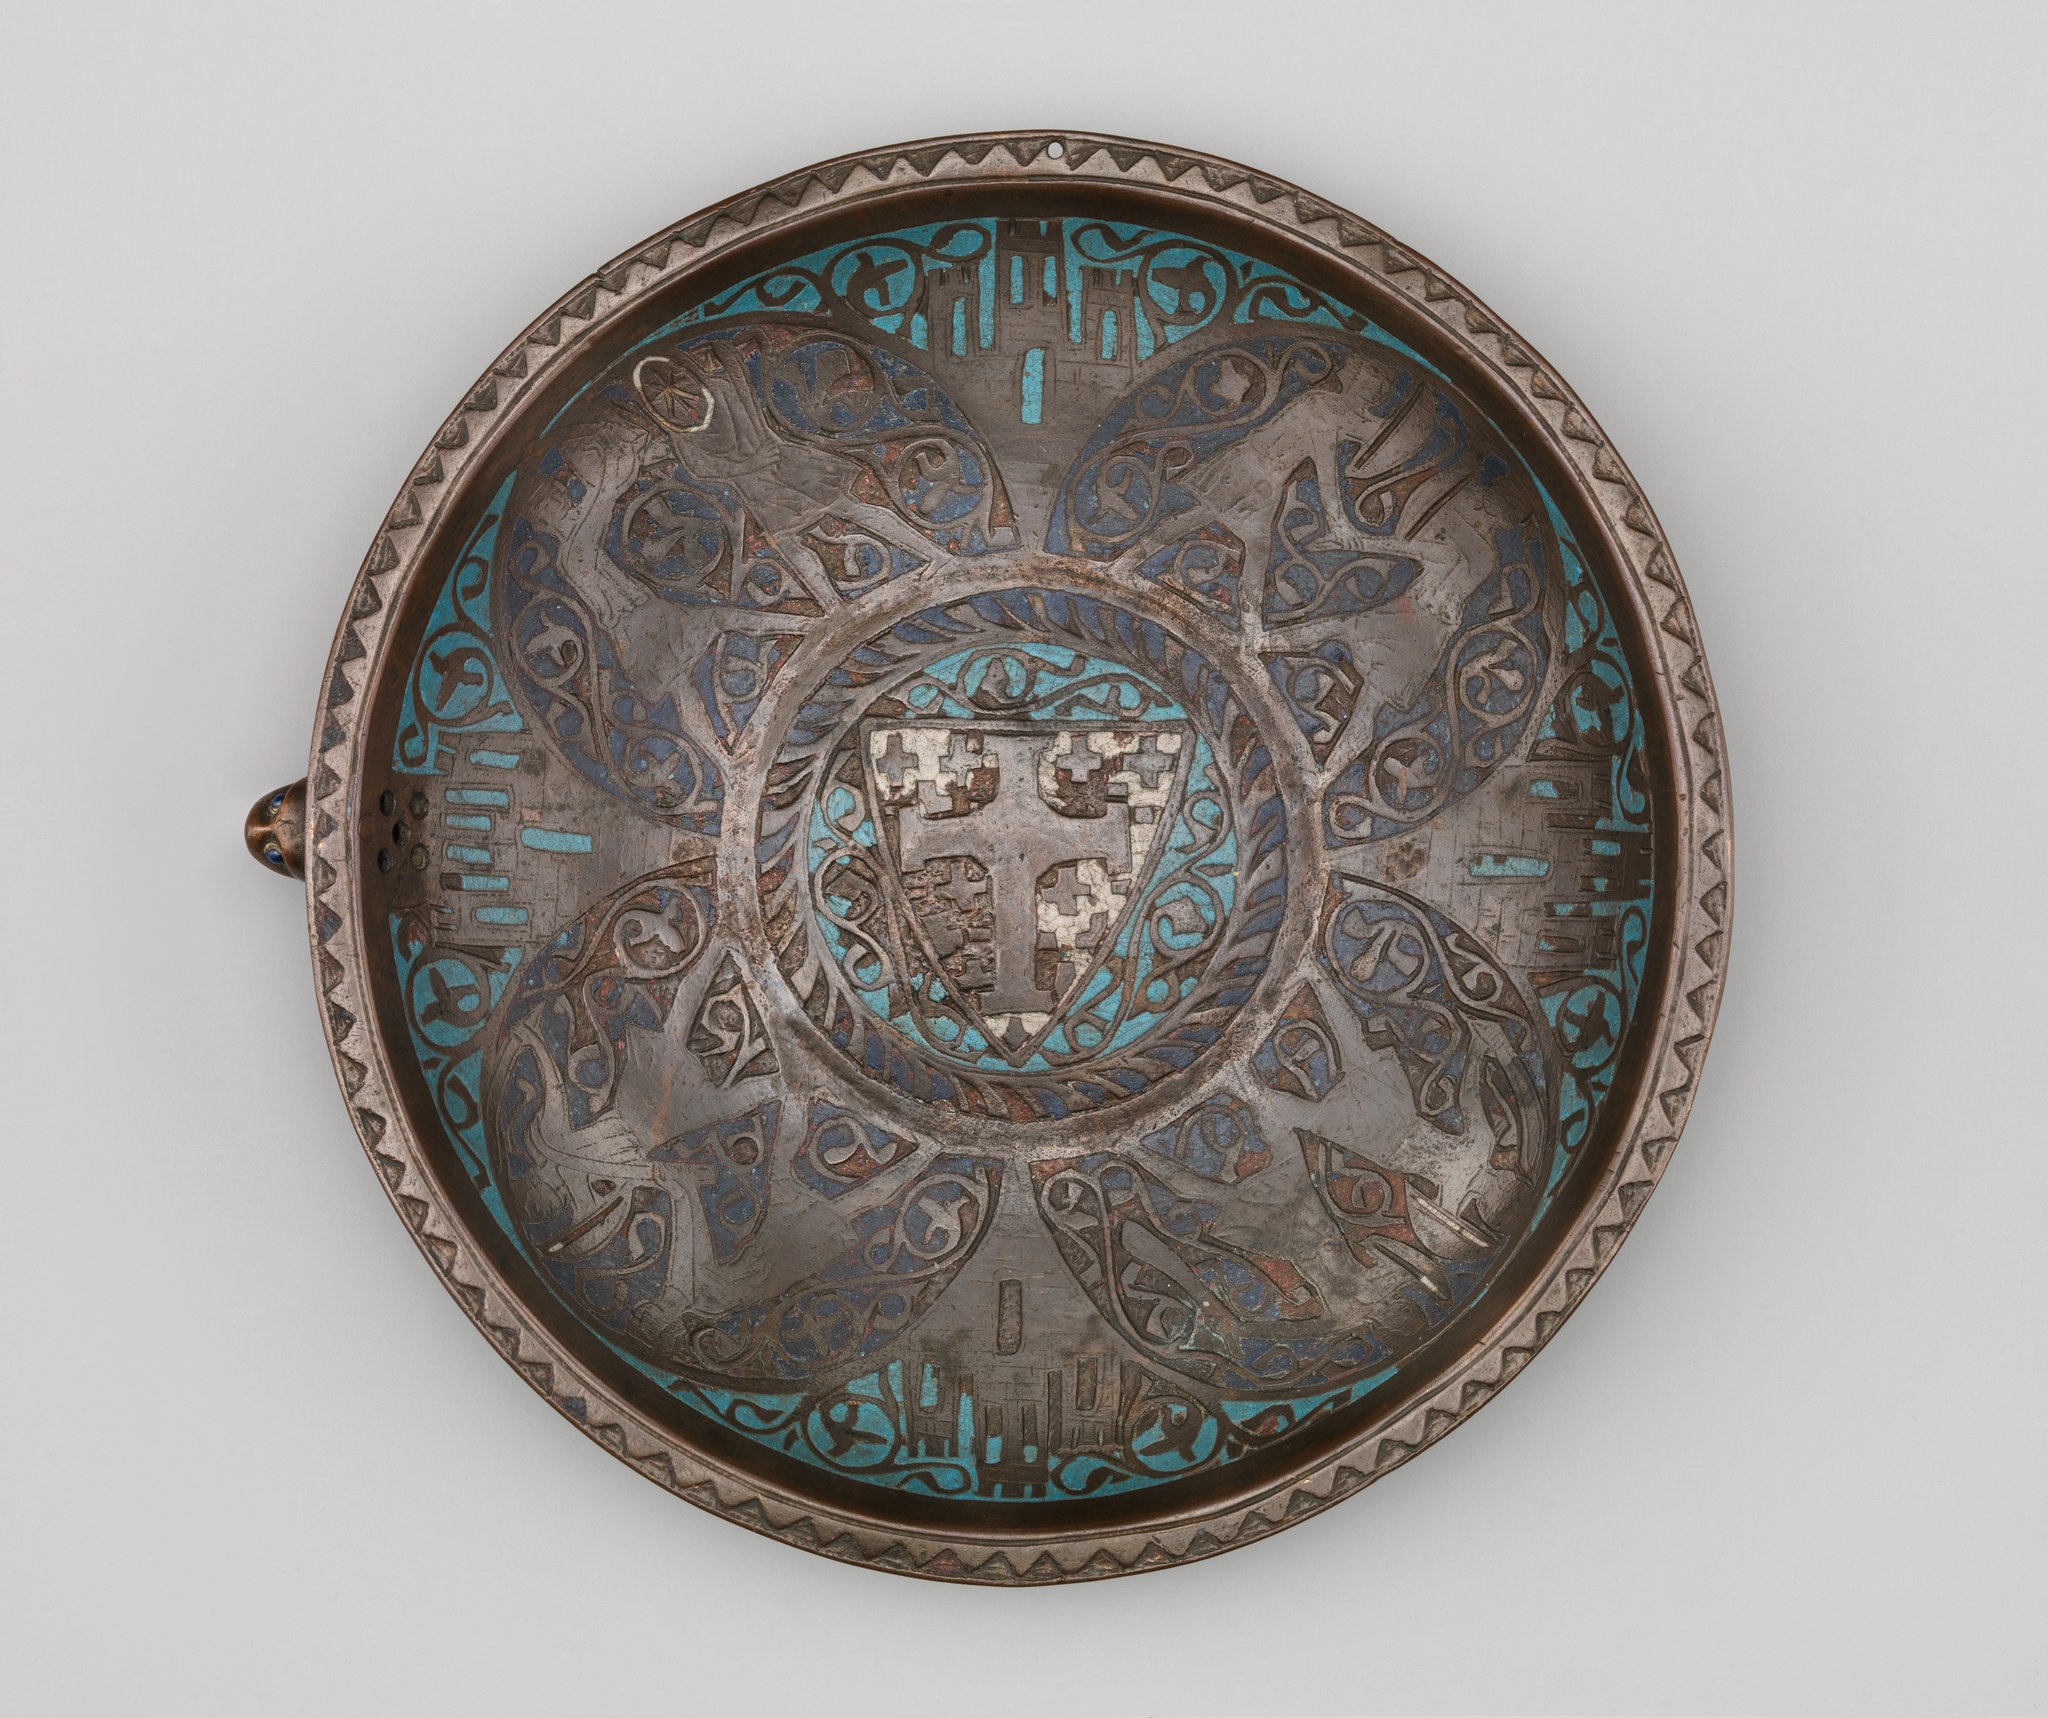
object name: gemellion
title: Gemellion (Hand Basin) with the Arms of the Latin Kingdom of Jerusalem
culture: french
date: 1250-1275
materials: copper, enamel, gilt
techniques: enamel, engraving, forming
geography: france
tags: men,cross,coat of arms